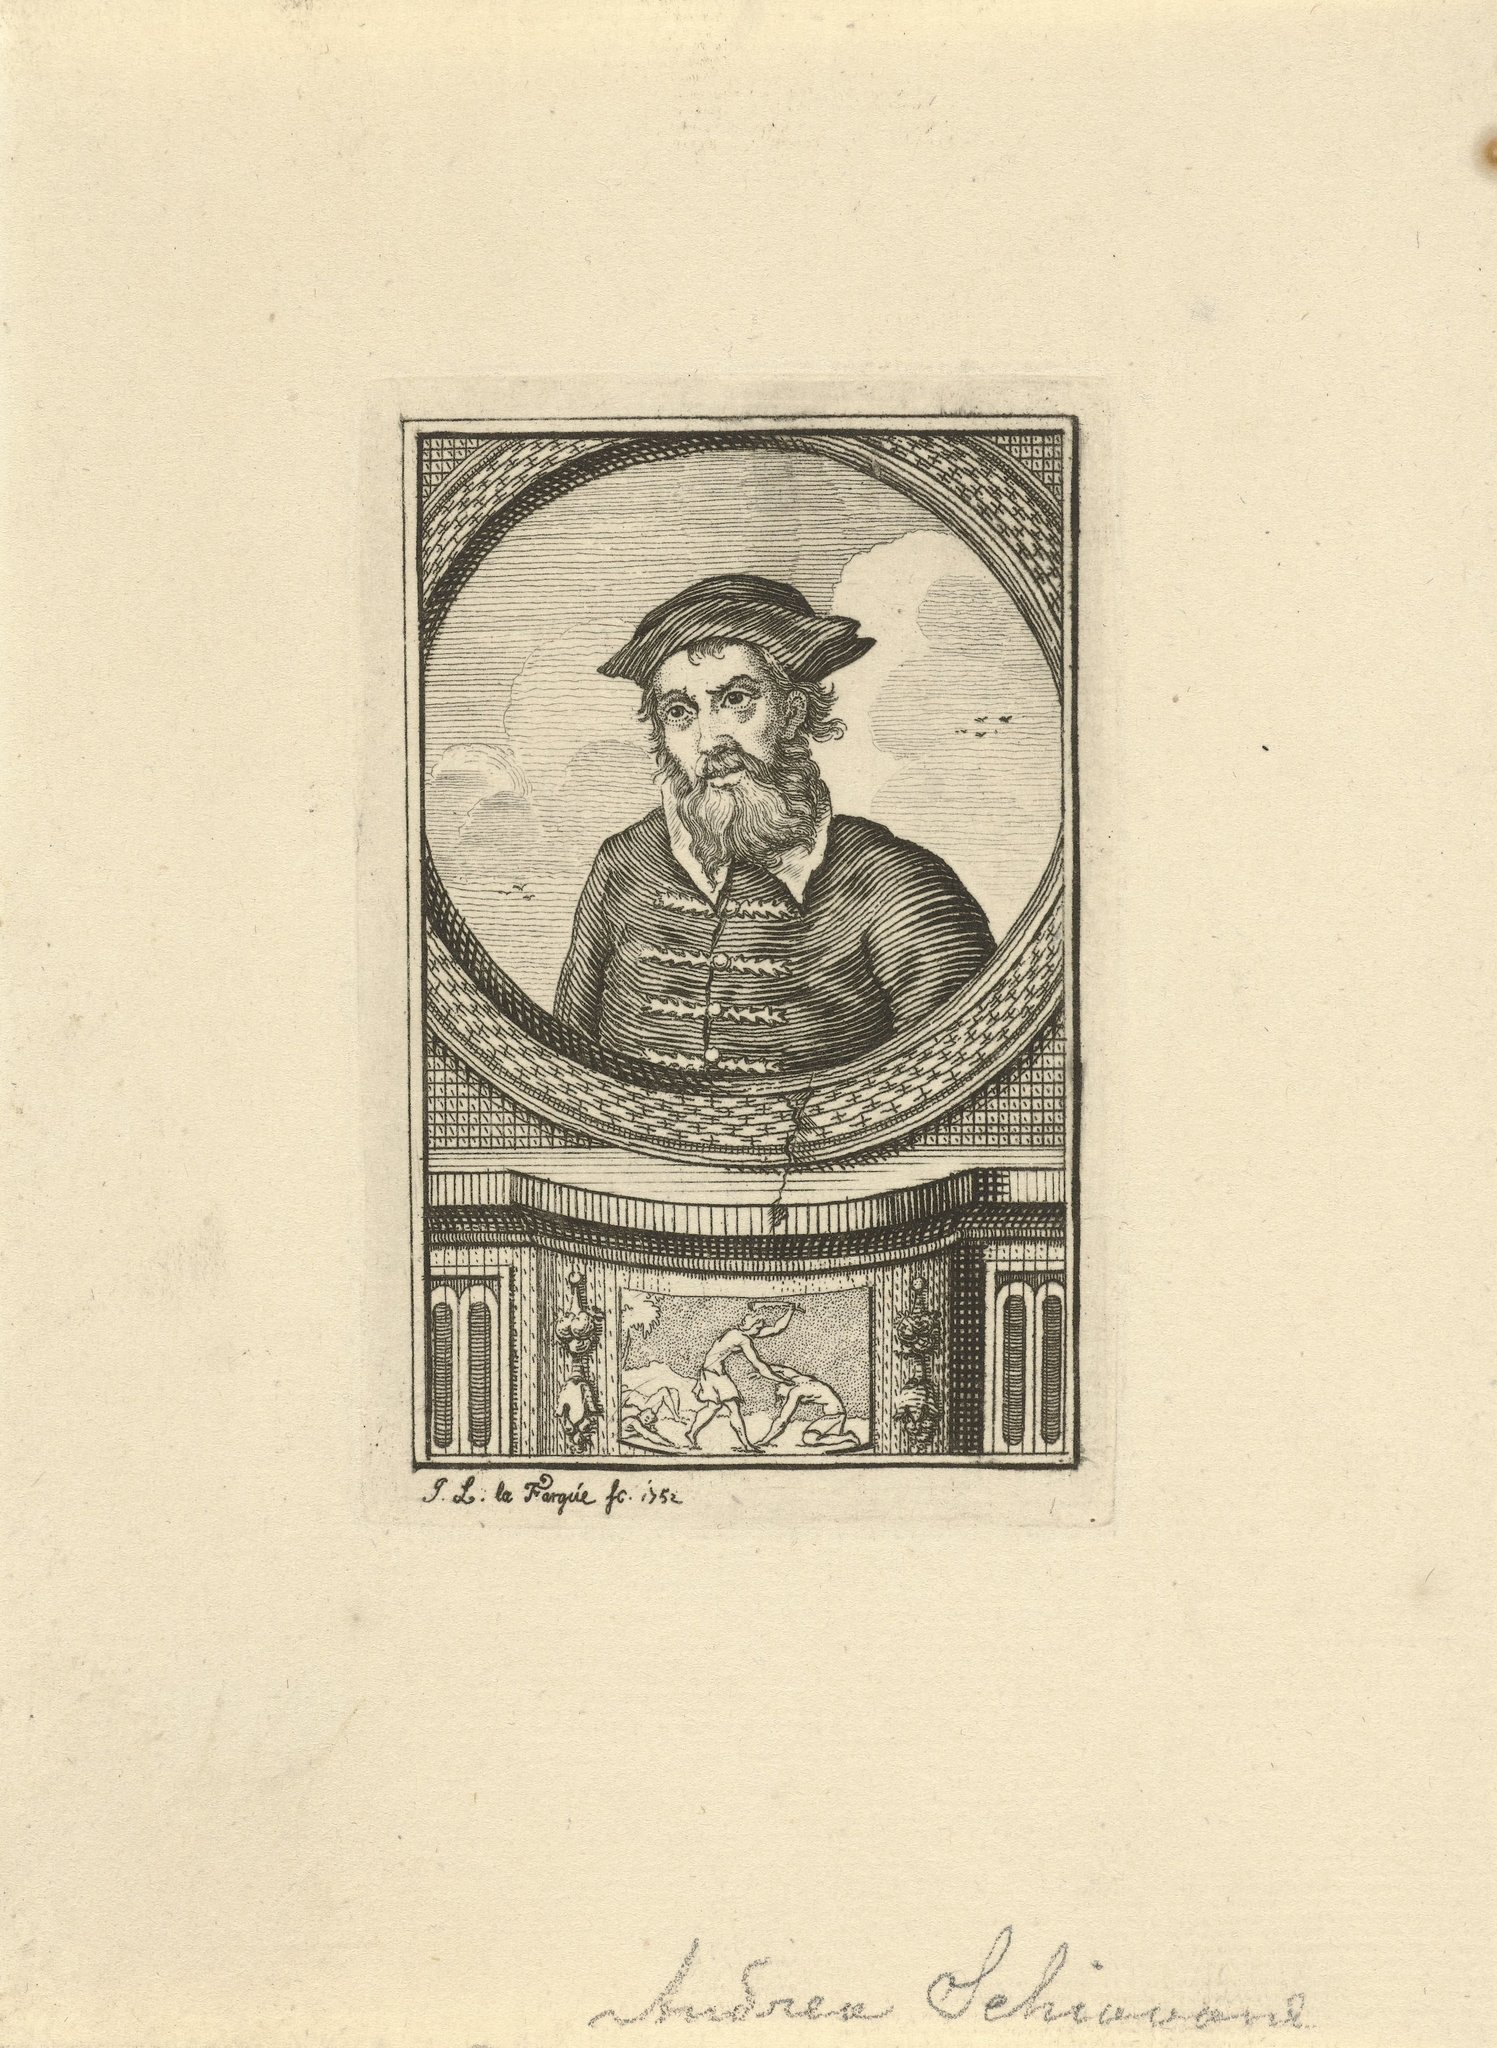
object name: print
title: Portretten van Italiaanse kunstenaars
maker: isaac lodewijk la fargue van nieuwland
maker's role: draughtsman, painter, print maker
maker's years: 1726-1805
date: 1752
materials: paper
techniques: etching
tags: venice, painter, print maker, draughtsman, schiavone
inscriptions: collector's mark: Lugt 2228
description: Prent opgenomen in: Dézallier d'Argenville, Antoine Joseph. Tooneel der uitmuntende schilders van Europa, en byzonderlyk van Nederland. Den Haag: Mattheus Gaillard, 1752.